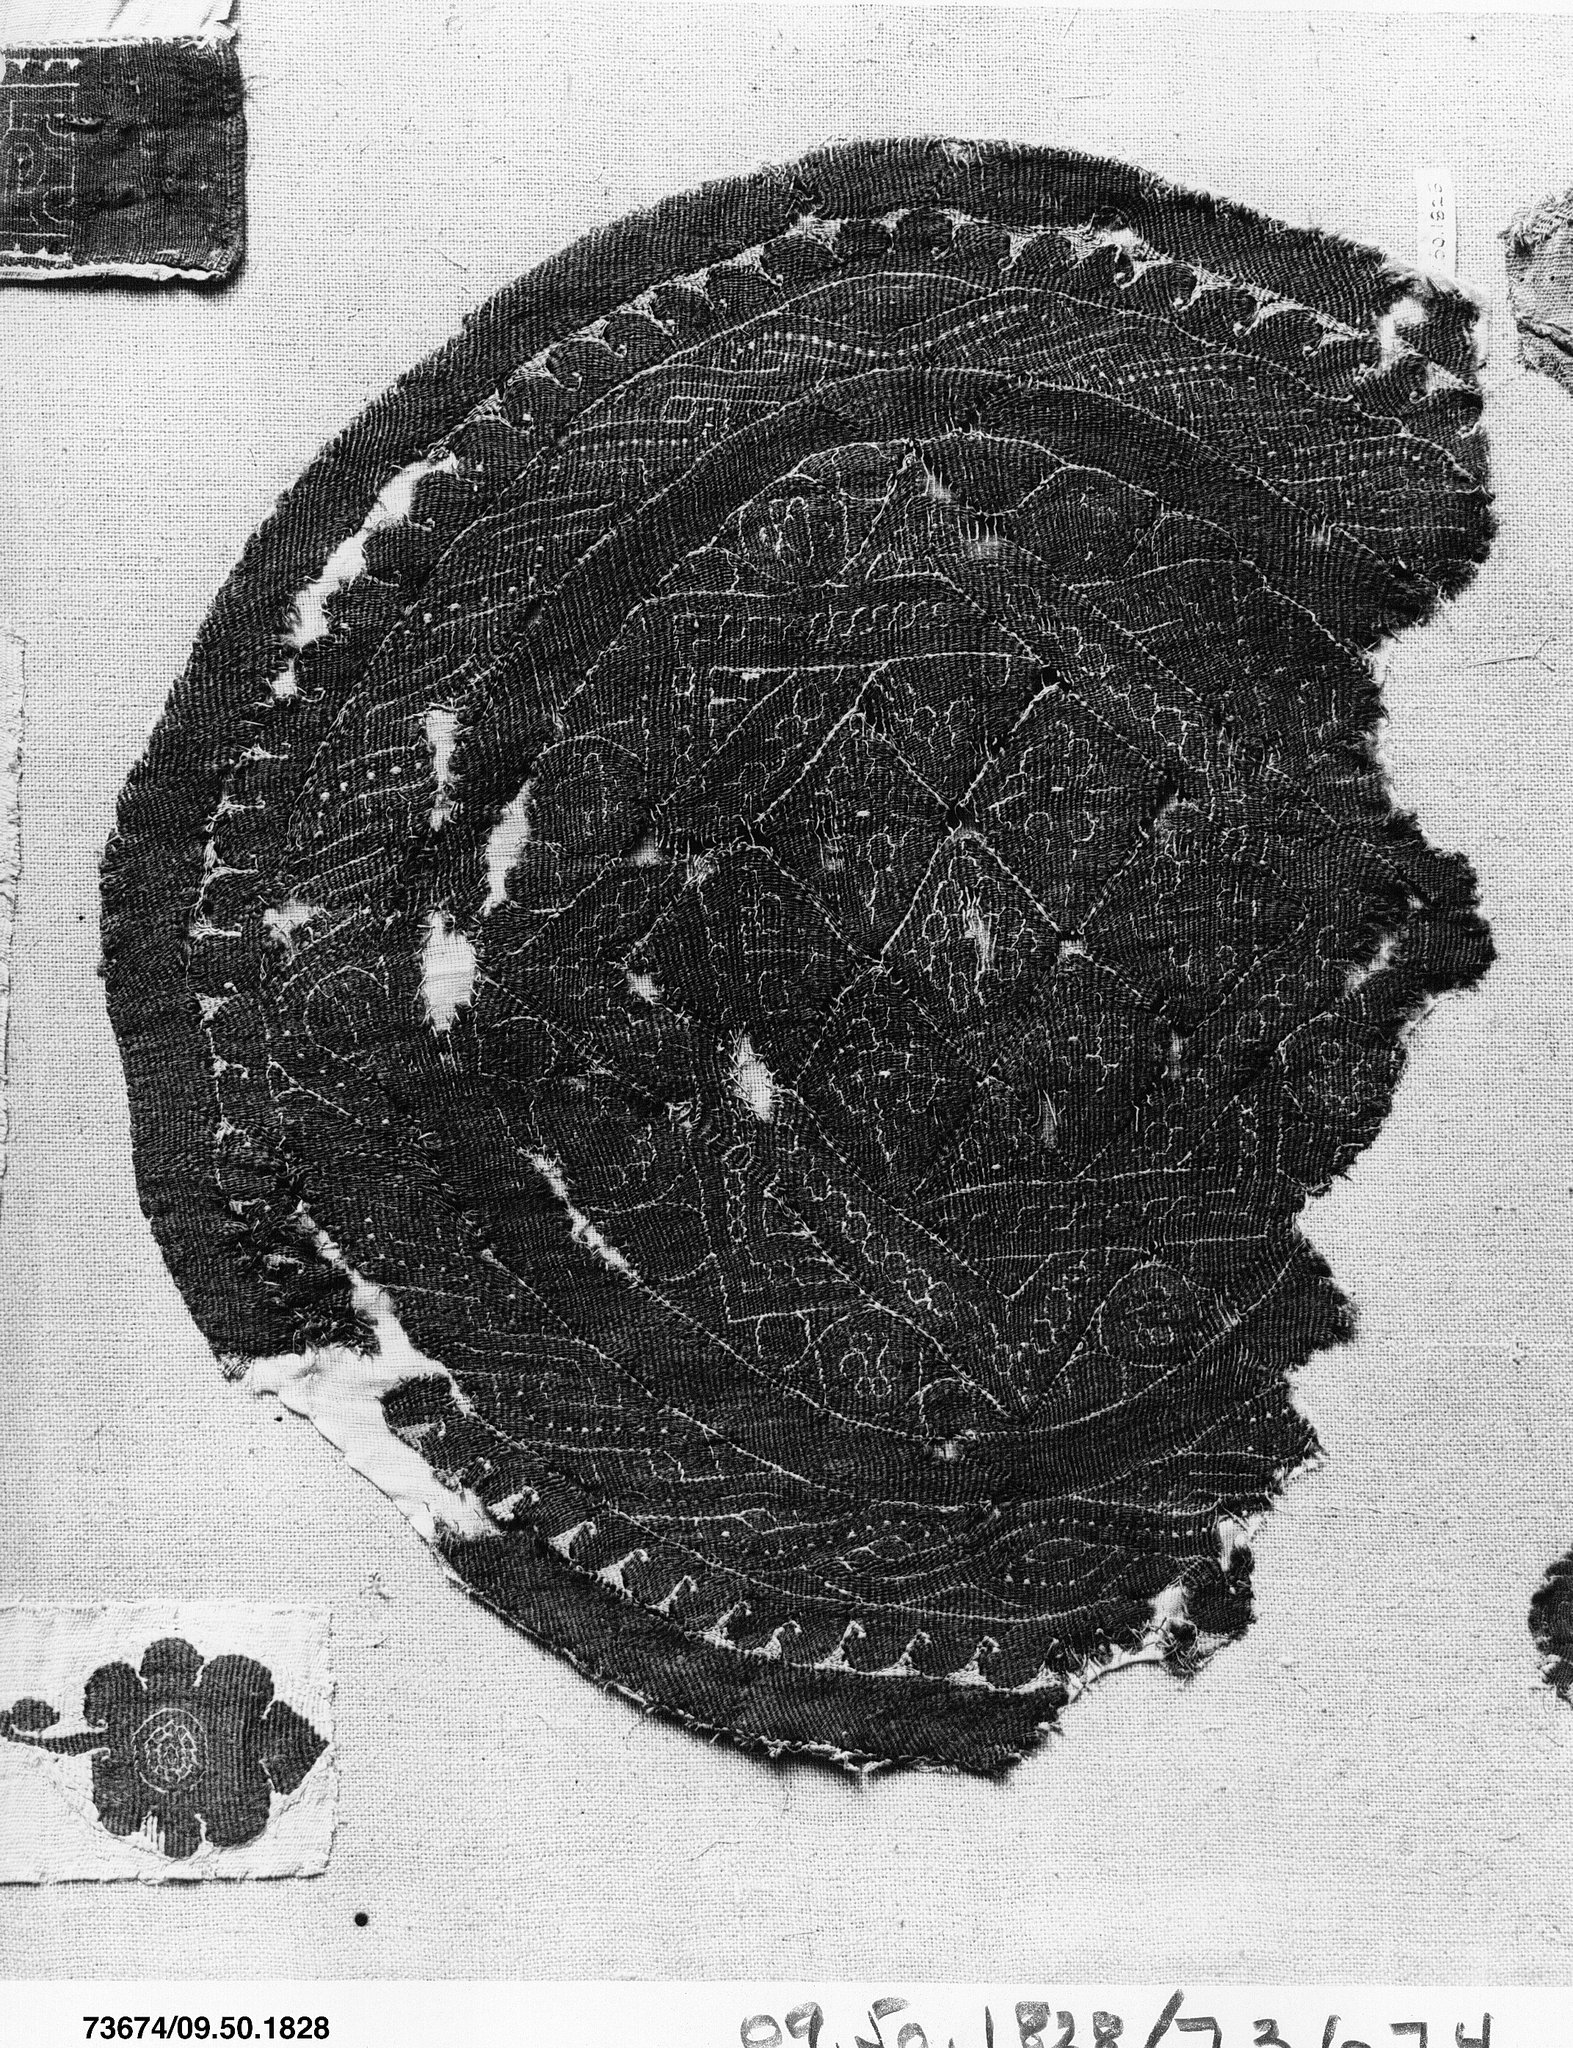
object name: roundel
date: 201-400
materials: linen, wool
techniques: weave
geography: egypt